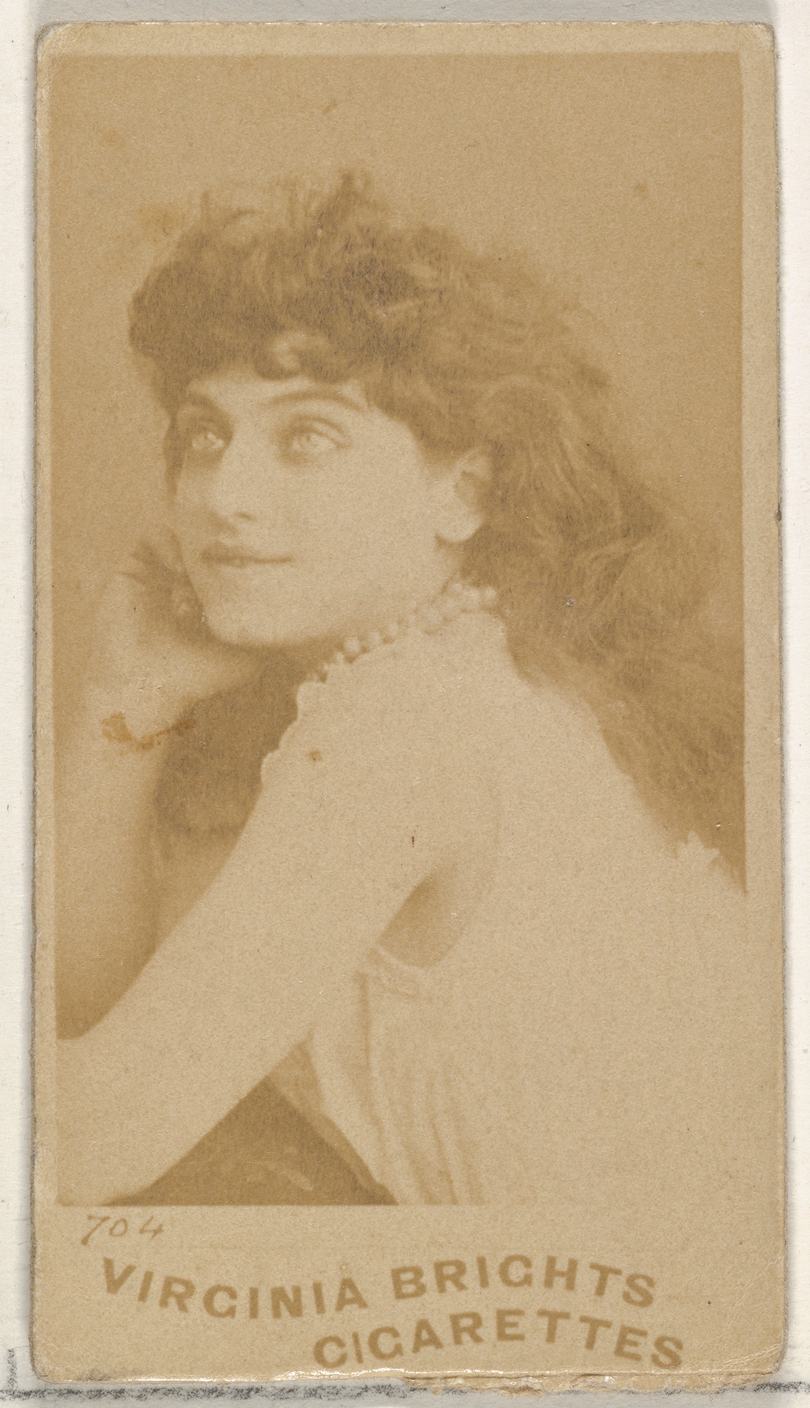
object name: photograph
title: Card 704, from the Actors and Actresses series (N45, Type 5) for Virginia Brights Cigarettes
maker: allen & ginter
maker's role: publisher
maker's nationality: american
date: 1888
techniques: albumen silver print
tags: portraits,women,actresses